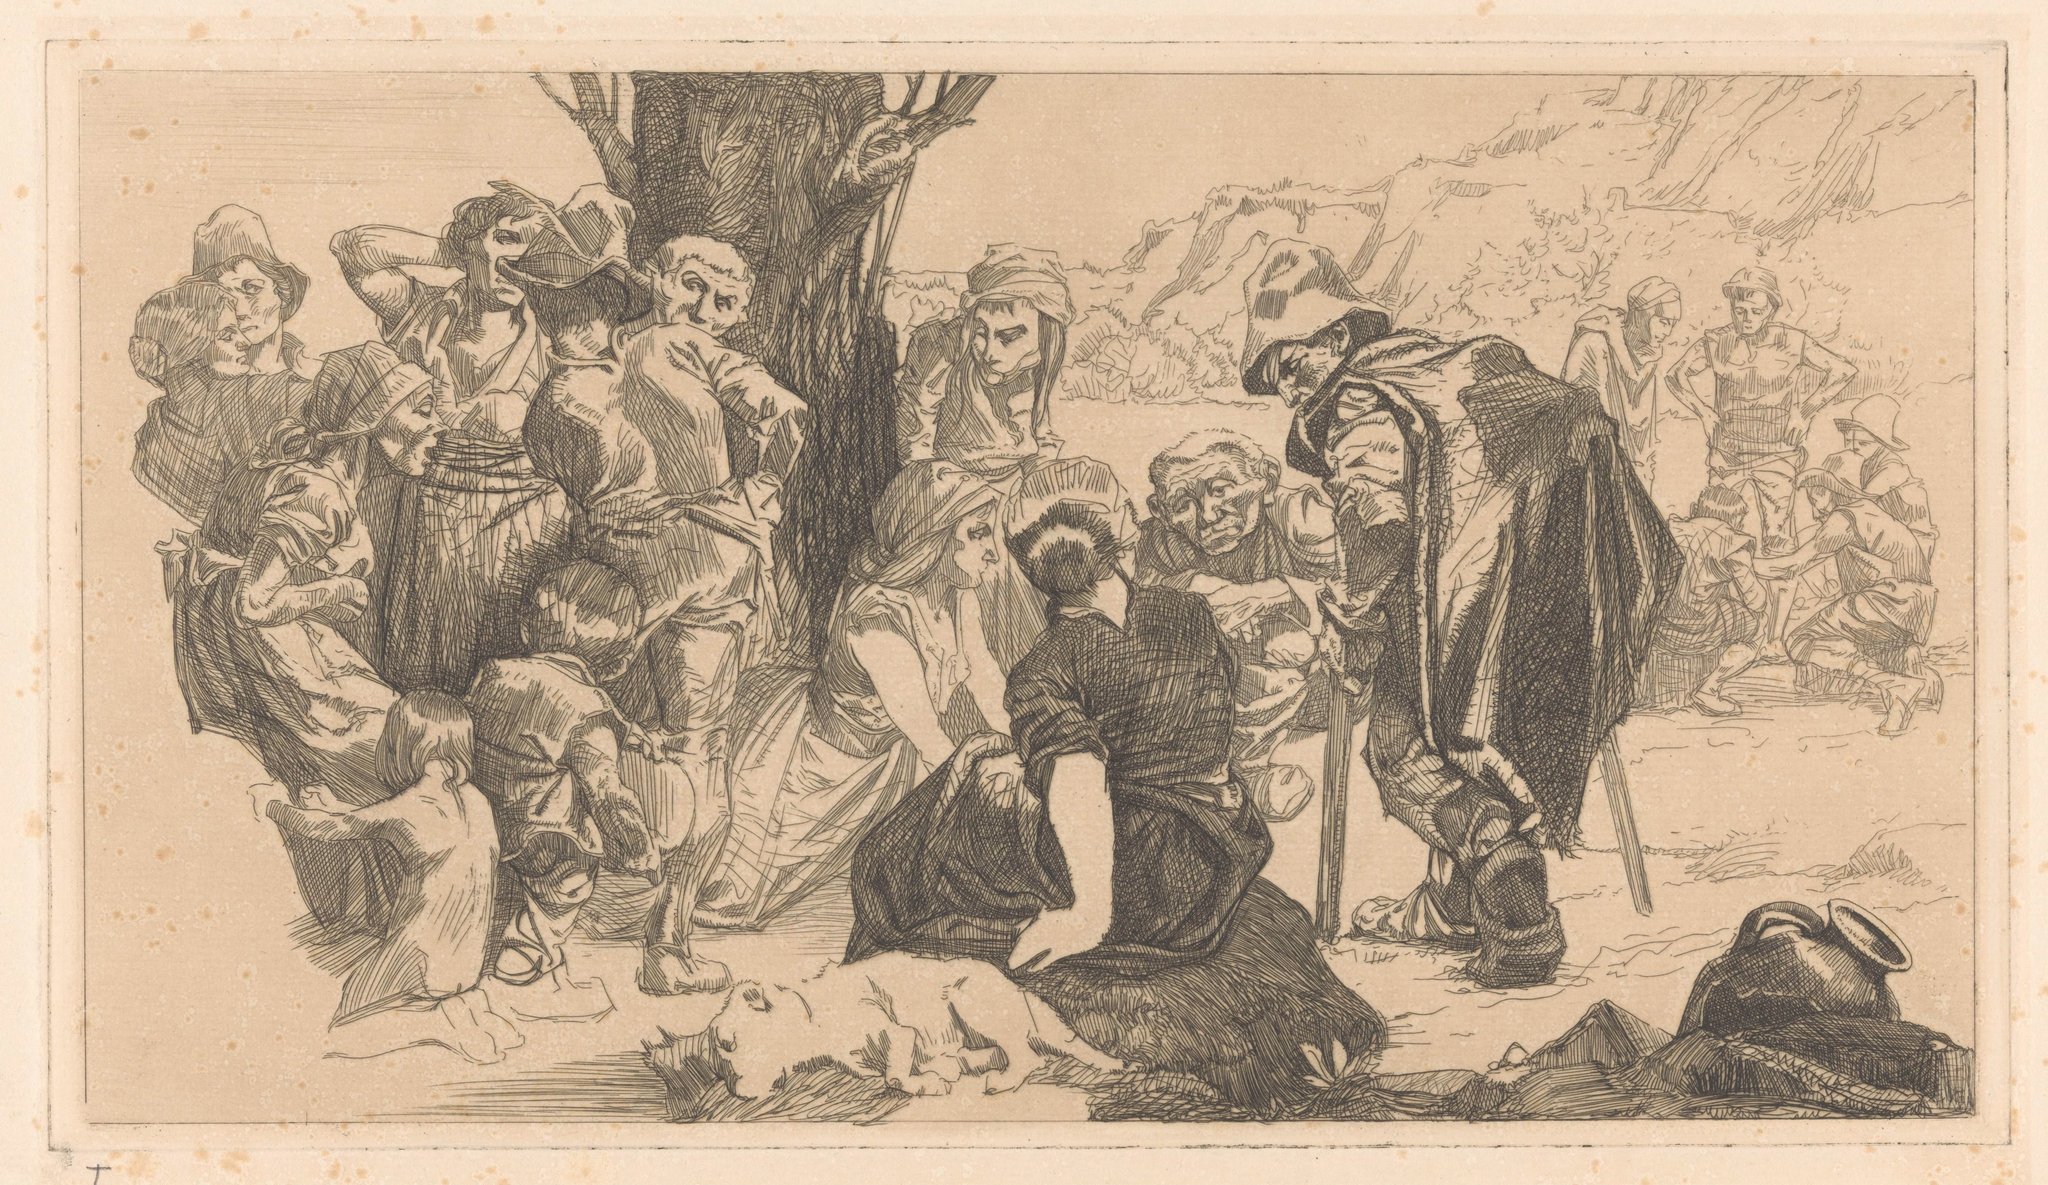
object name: print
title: Zigeuners en landlopers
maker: johannes josephus aarts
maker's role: draughtsman, print maker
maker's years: 1871-1934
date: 1881-1934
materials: paper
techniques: etching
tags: crutches, wandering communities: romani or roma, wandering communities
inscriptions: collector's mark: Lugt 2228, collector's mark: Lugt 2760, collector's mark: Lugt 2166, watermark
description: Een groep mannen, vrouwen en kinderen, waarschijnlijk landlopers, houdt zich op bij een boom. Rechts op de voorgrond loopt een man met twee krukken. Achter de groep een open landschap, dat begrensd wordt door heuvels.